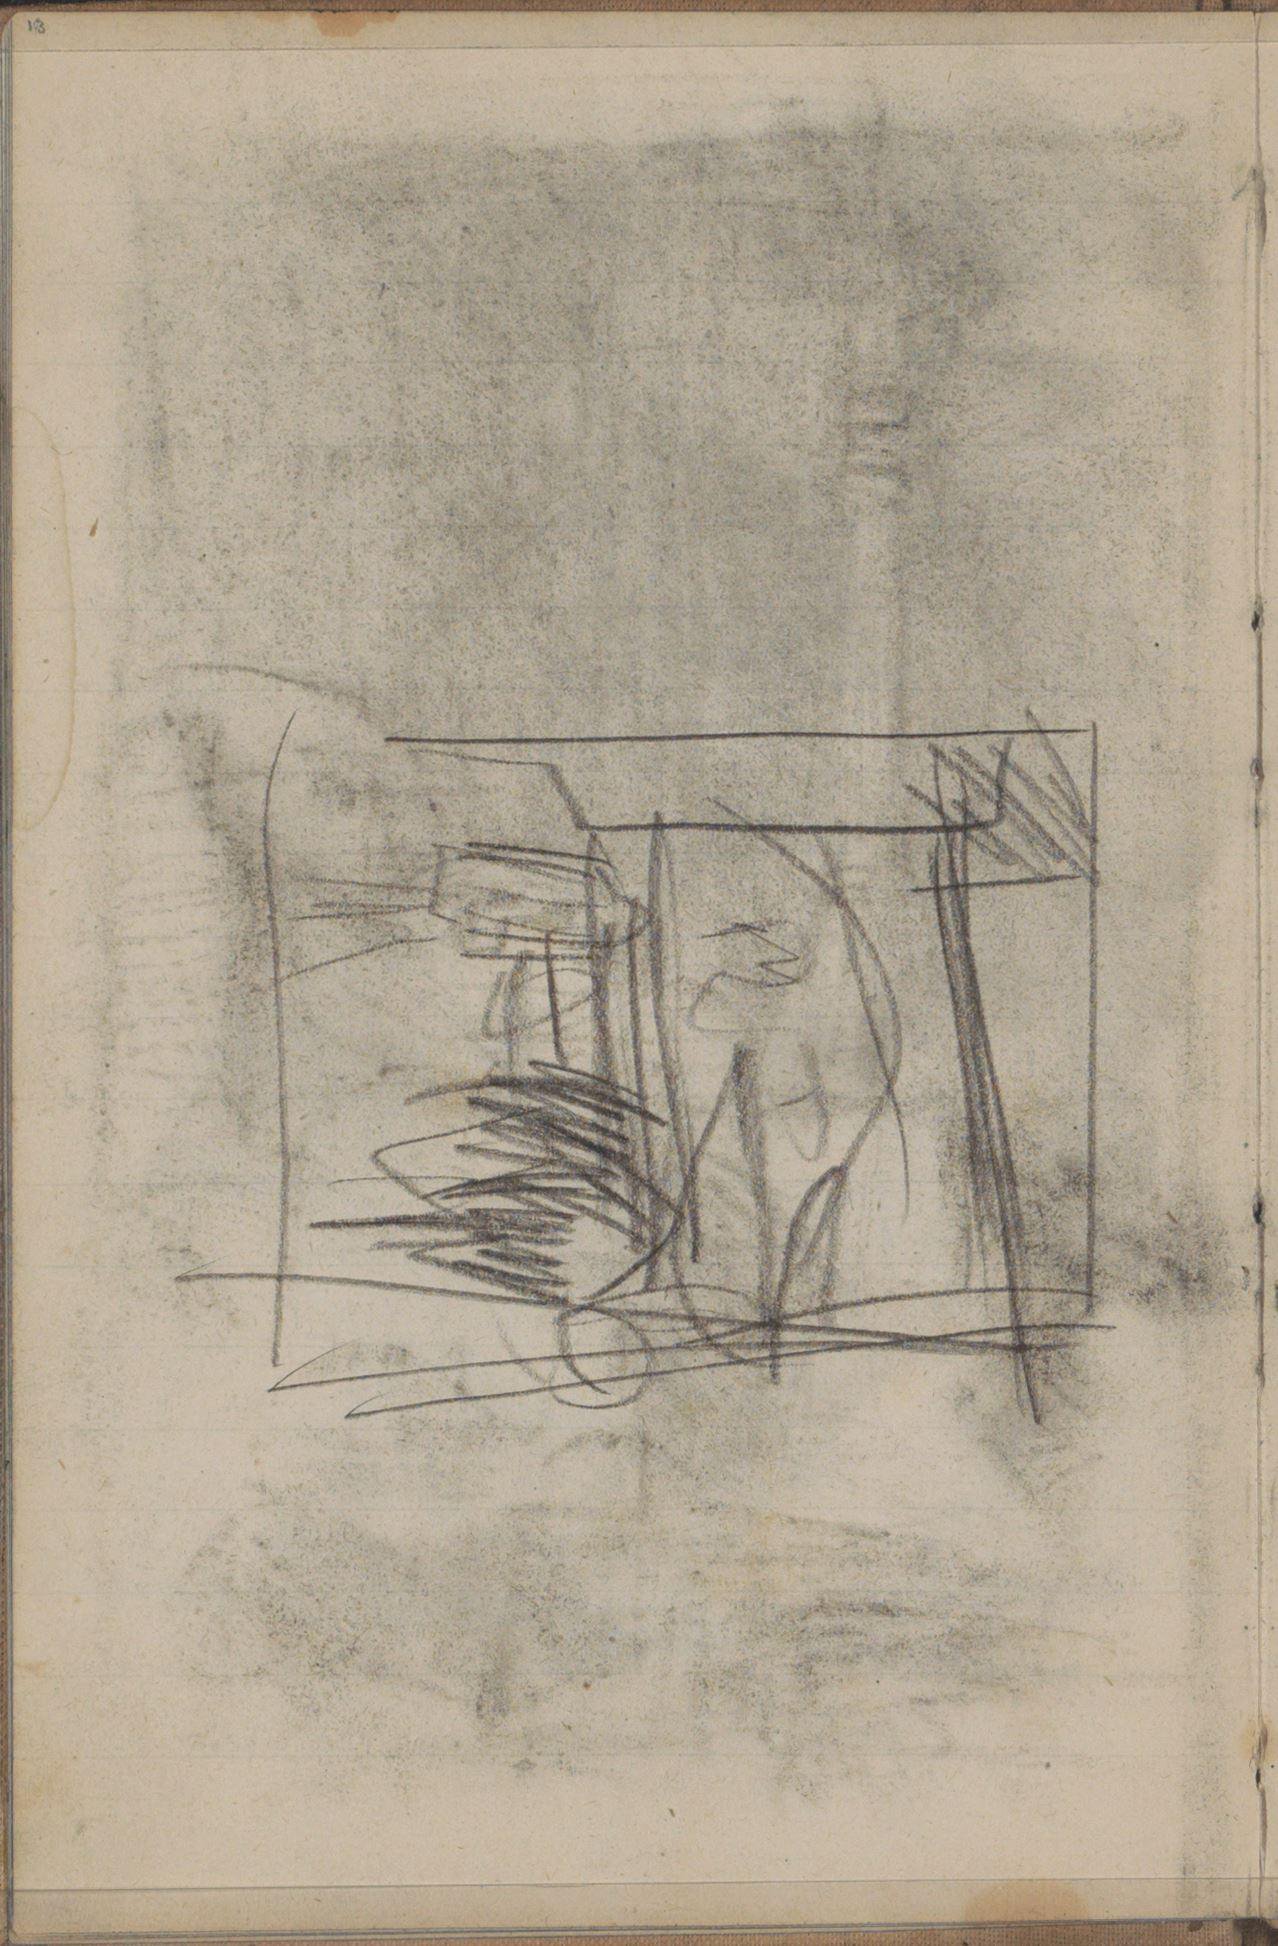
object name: sketchbook leaf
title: Studie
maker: marius bauer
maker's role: draughtsman, print maker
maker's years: 1867-1932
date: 1888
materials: chalk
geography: istanbul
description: Pagina 13 uit een schetsboek met 58 bladen.